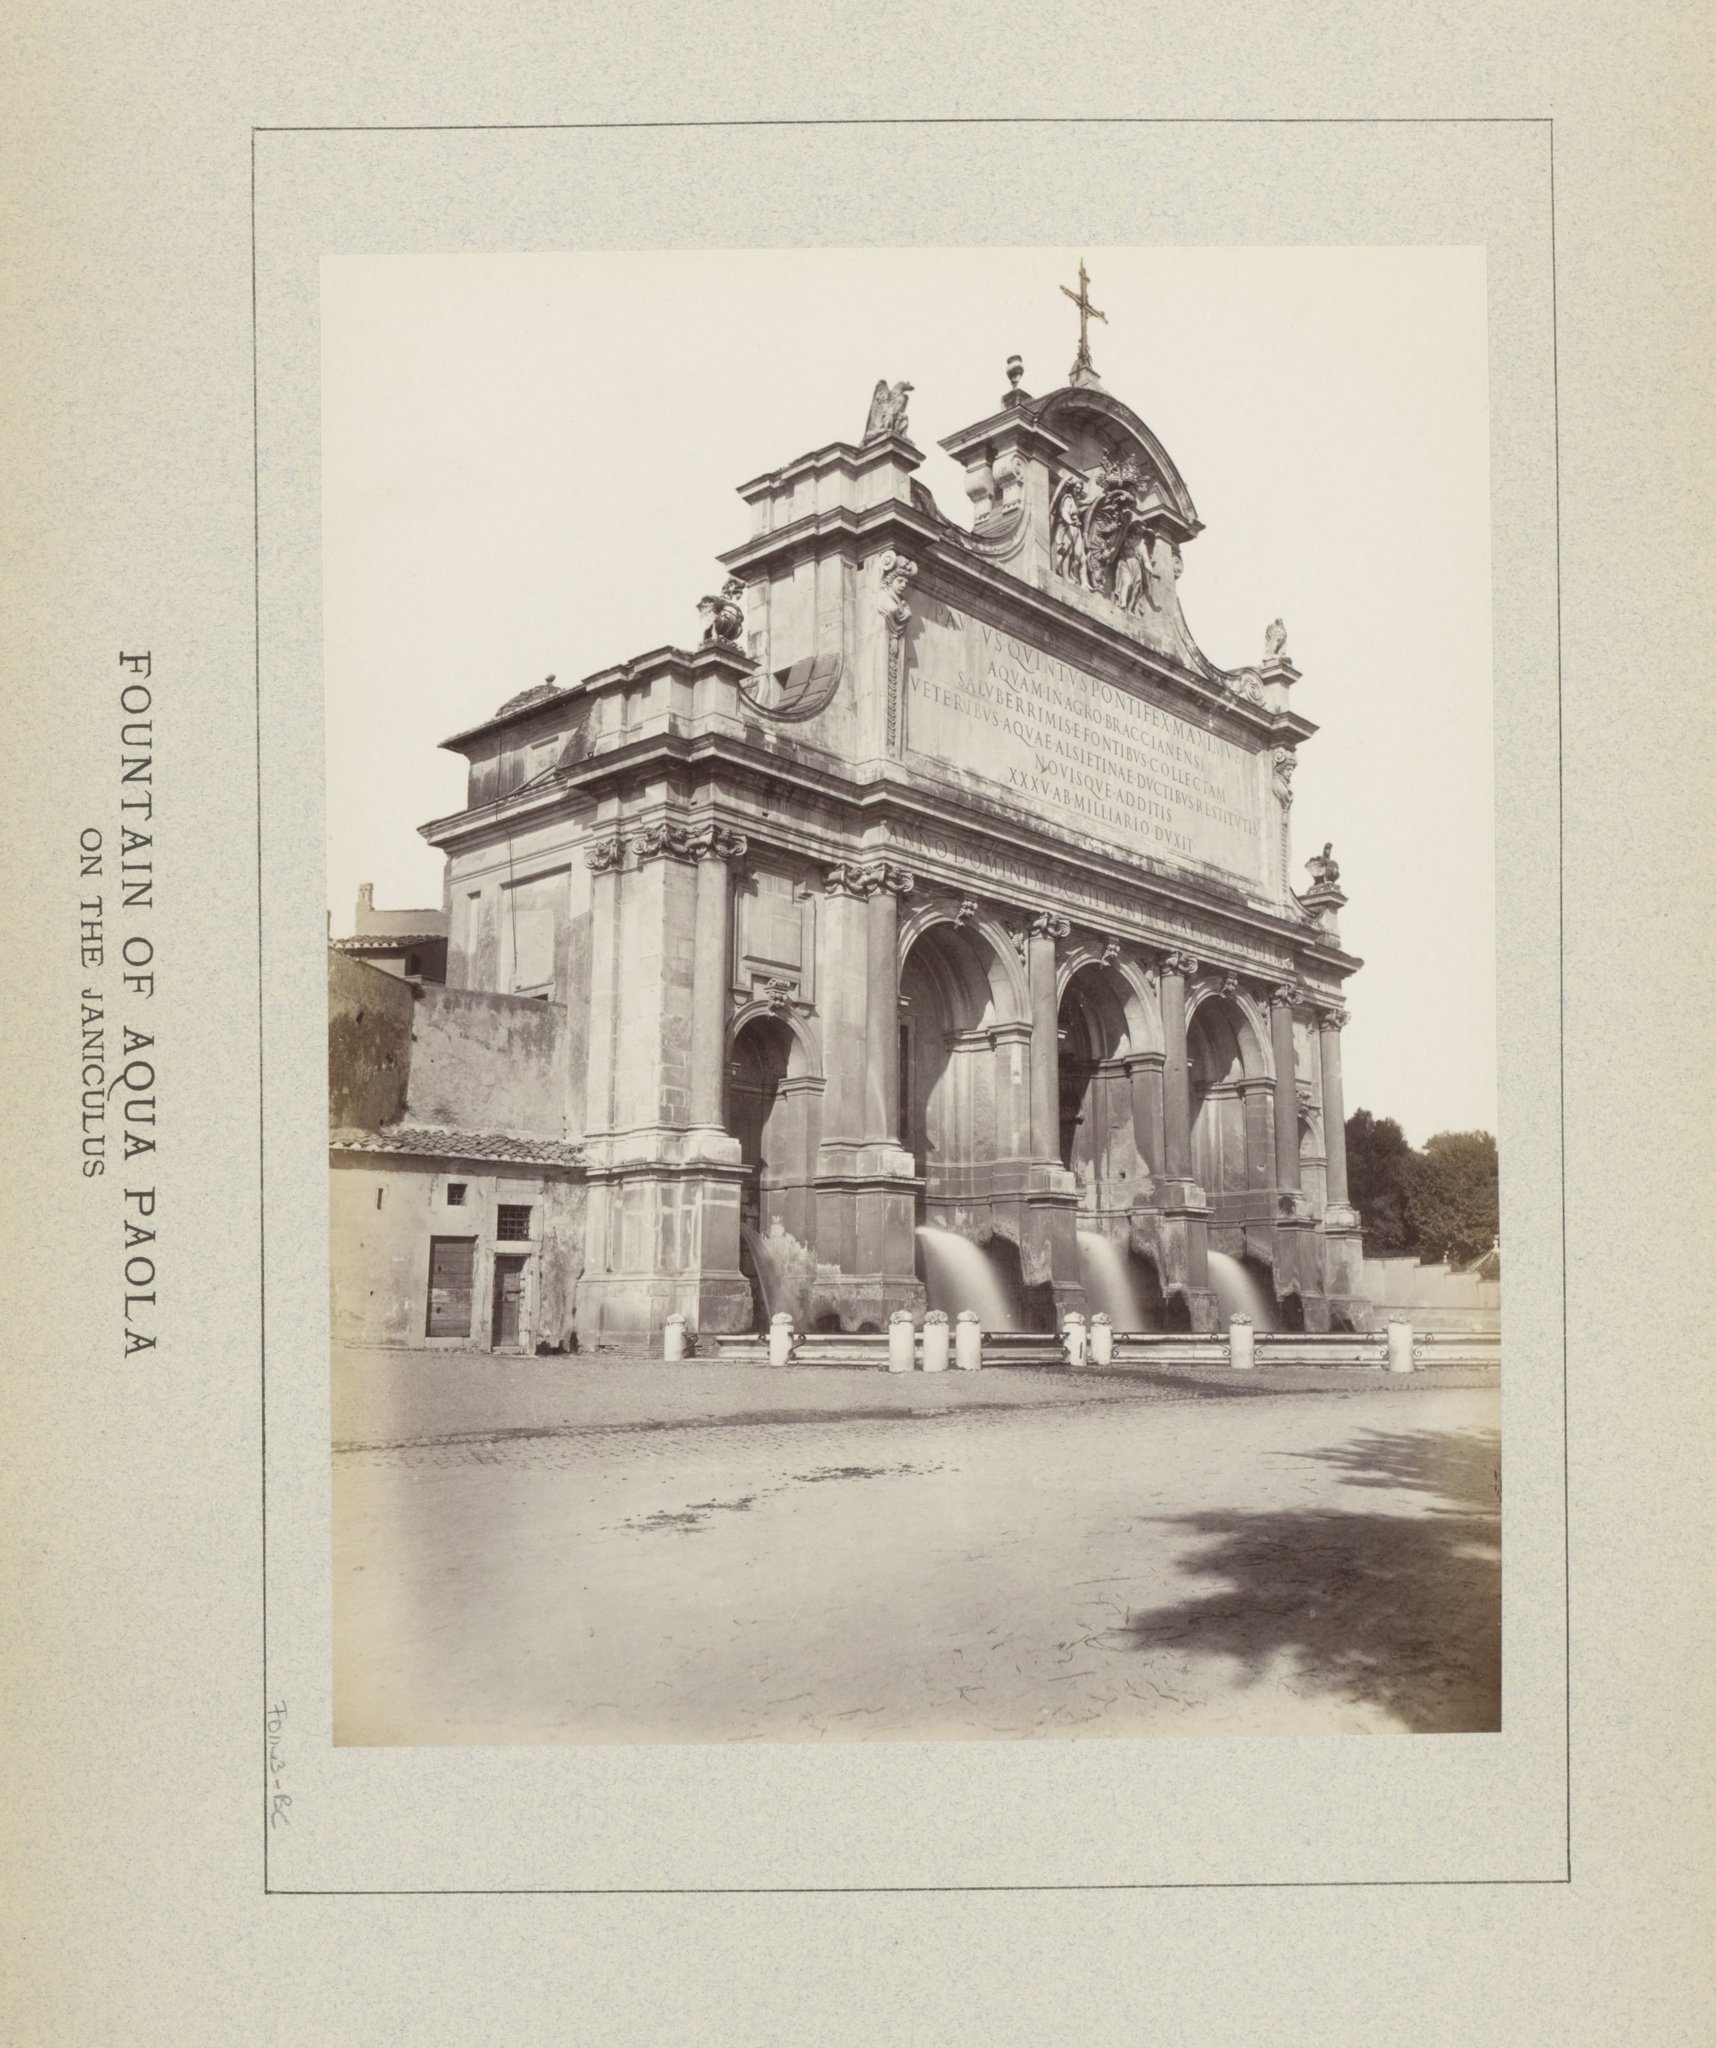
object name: photograph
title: Fountain of Aqua Paola on the Janiculus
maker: Anonymous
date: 1860-1900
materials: photographic support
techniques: albumen print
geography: rome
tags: ornamental fountain (+ city(-scape) with figures, staffage), rome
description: Onderdeel van Fotoalbum met opnames van bezienswaardigheden en kunstwerken in Rome.